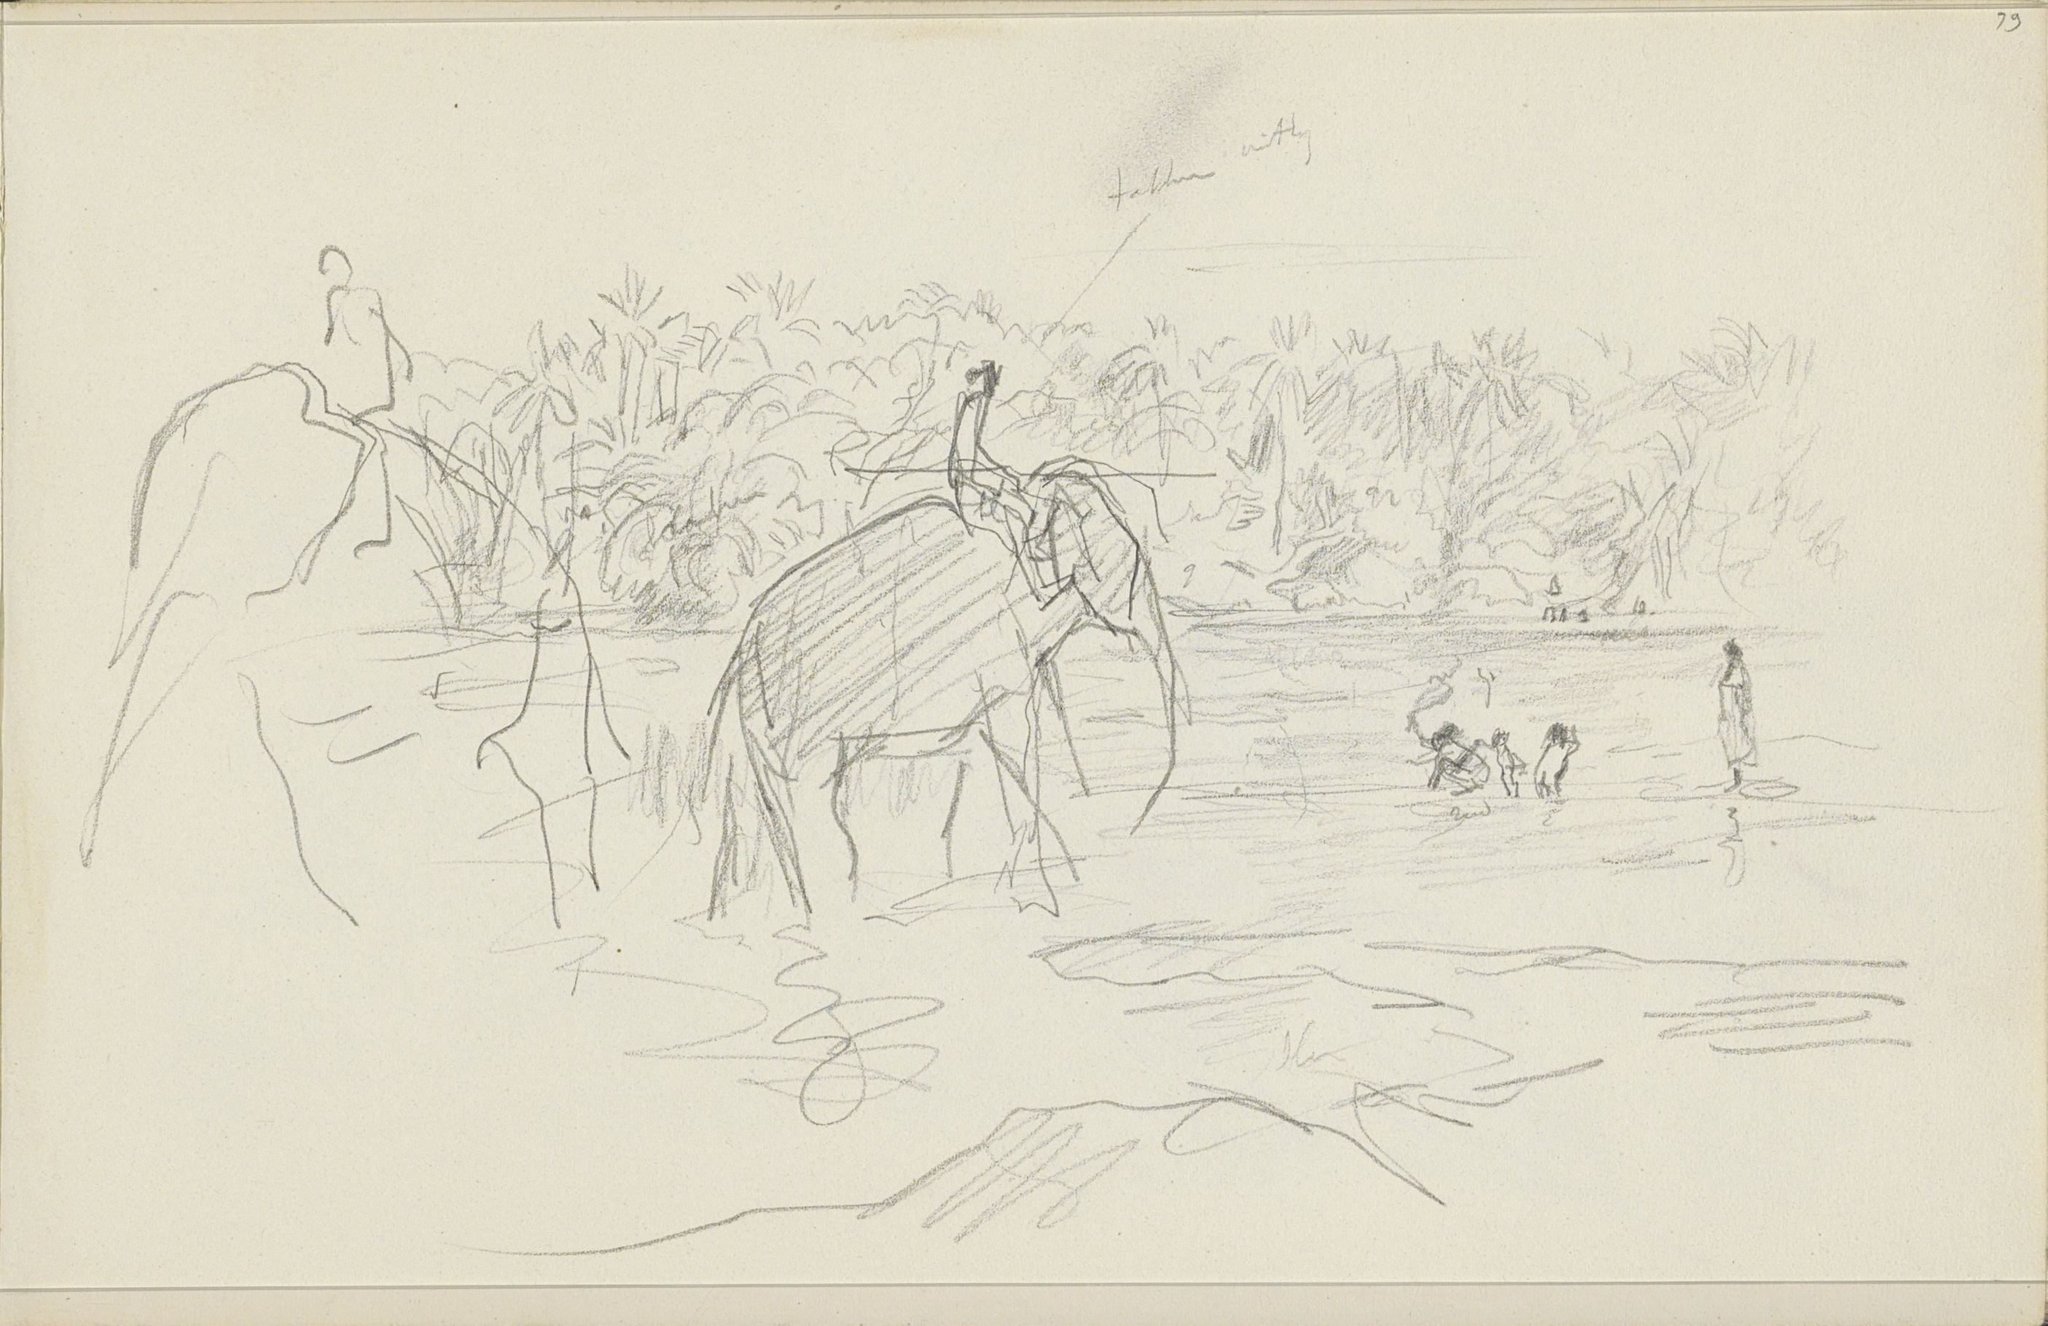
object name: sketchbook leaf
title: Olifanten in het oerwoud van India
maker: marius bauer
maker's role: draughtsman, print maker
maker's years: 1867-1932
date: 1924-1925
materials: paper, pencil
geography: india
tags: sitting figure, jungle, trunked animals: elephant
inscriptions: kleurnotitie, handgeschreven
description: De olifanten worden bereden. Ze lopen door laag water waar ook enkele figuren in staan. Pagina 79 uit een schetsboek met 48 bladen.